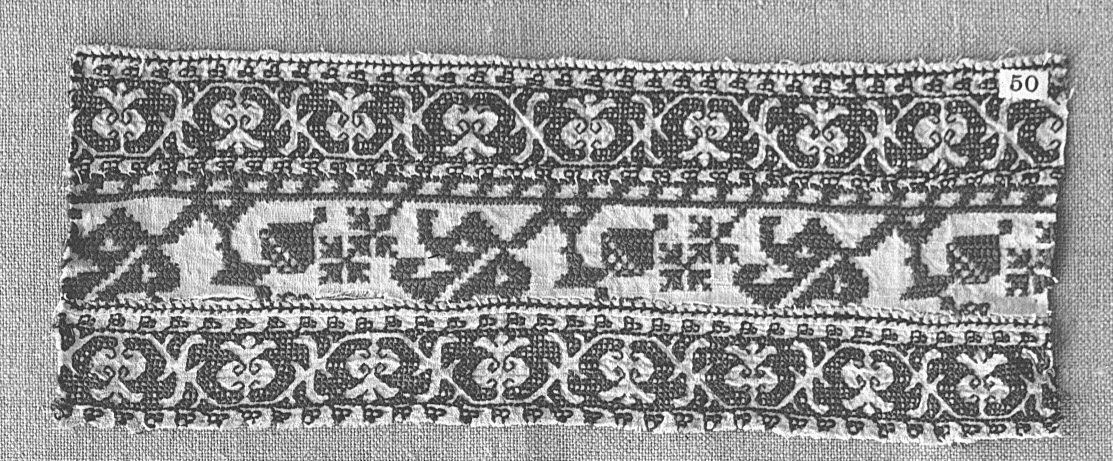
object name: band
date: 1501-1700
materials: linen, silk